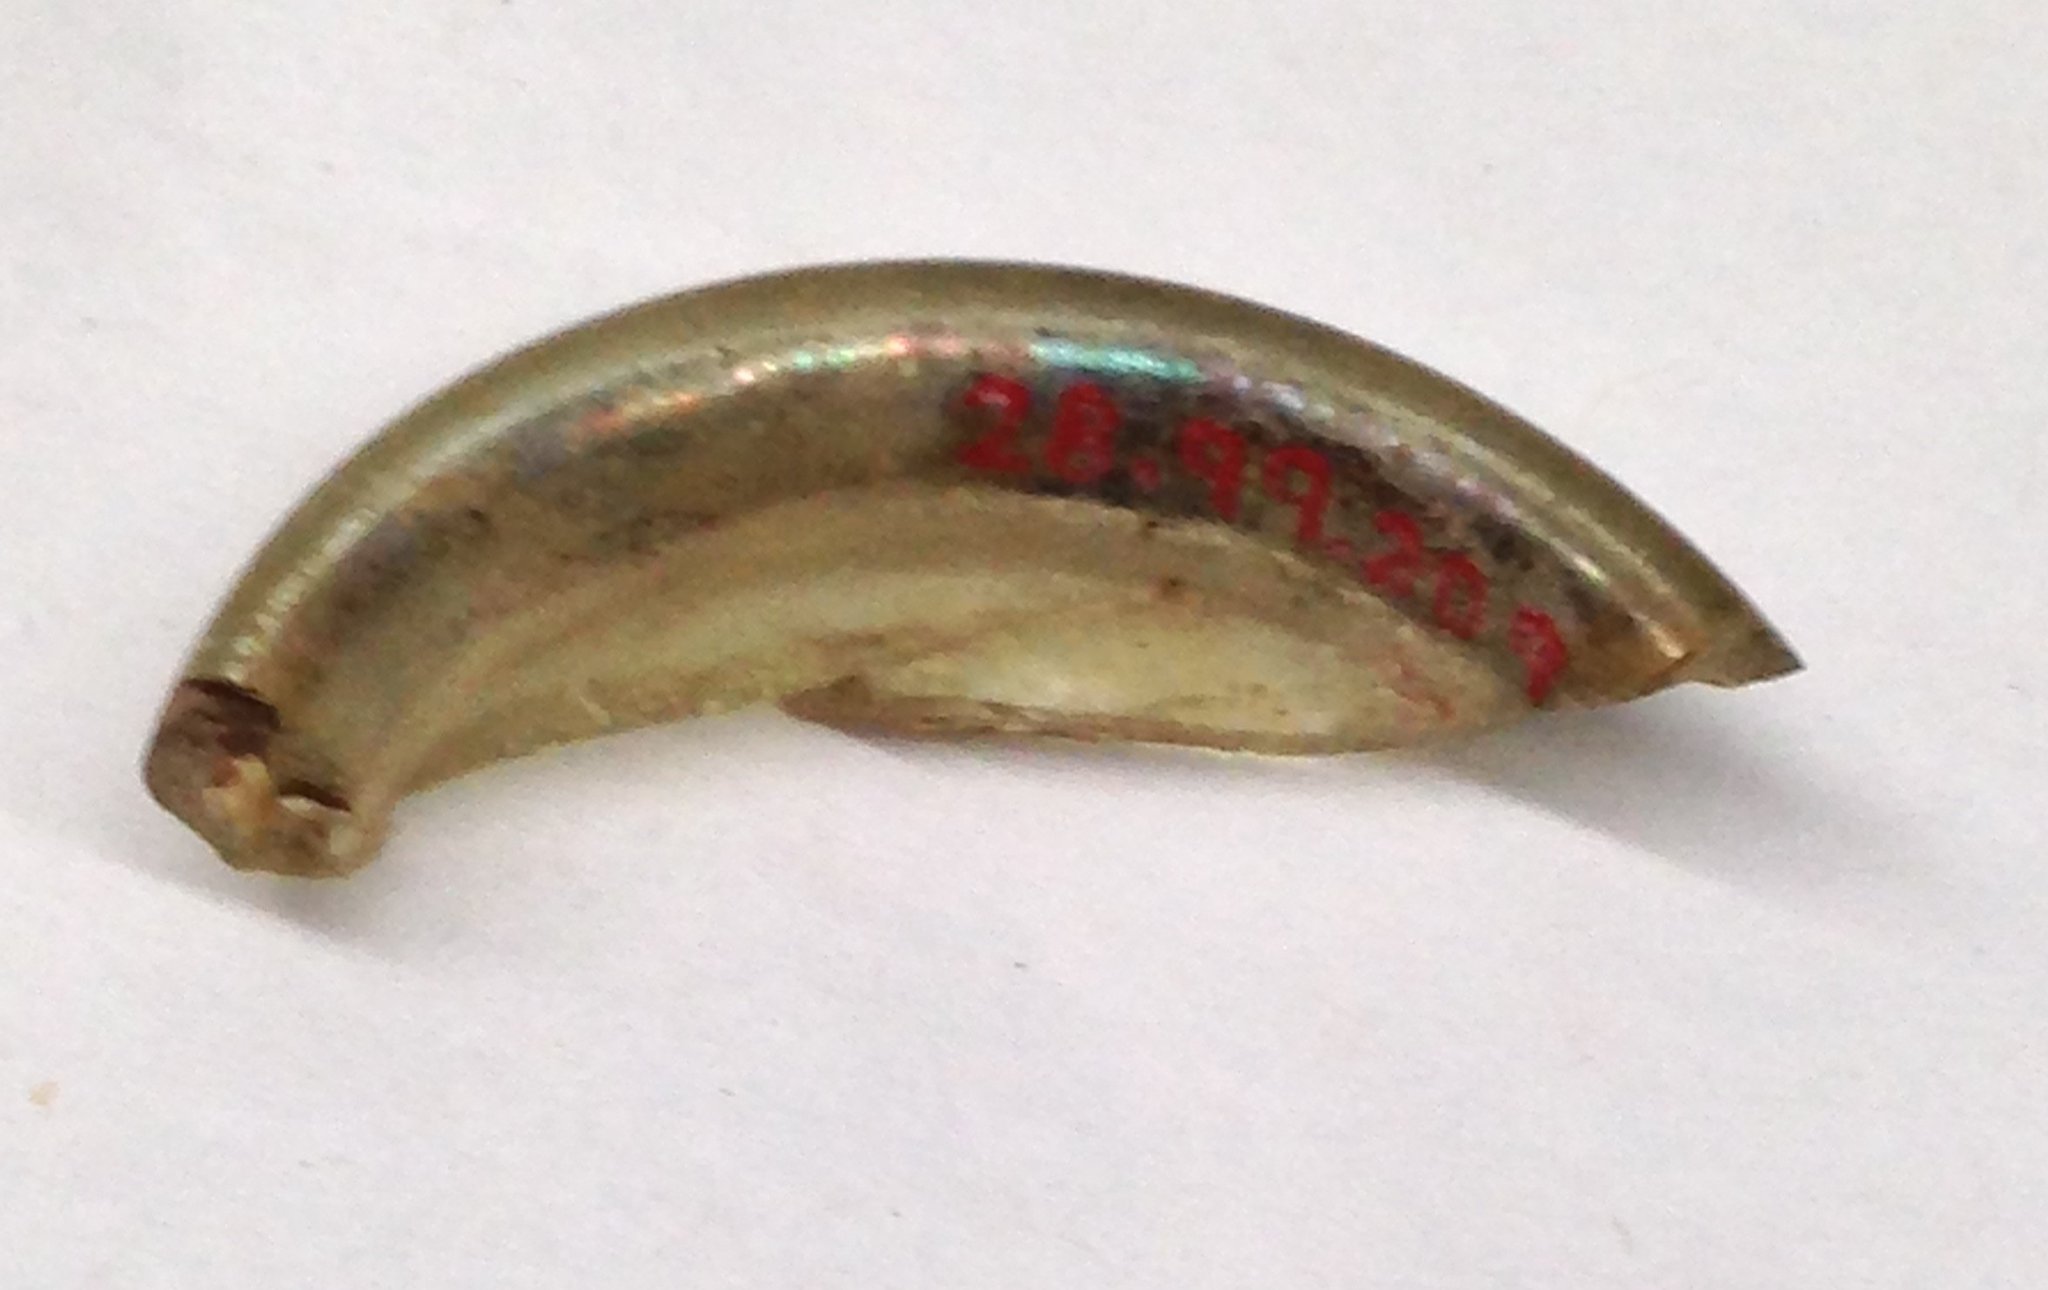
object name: fragment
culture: european or middle eastern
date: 1150-1250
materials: ceramic, glass